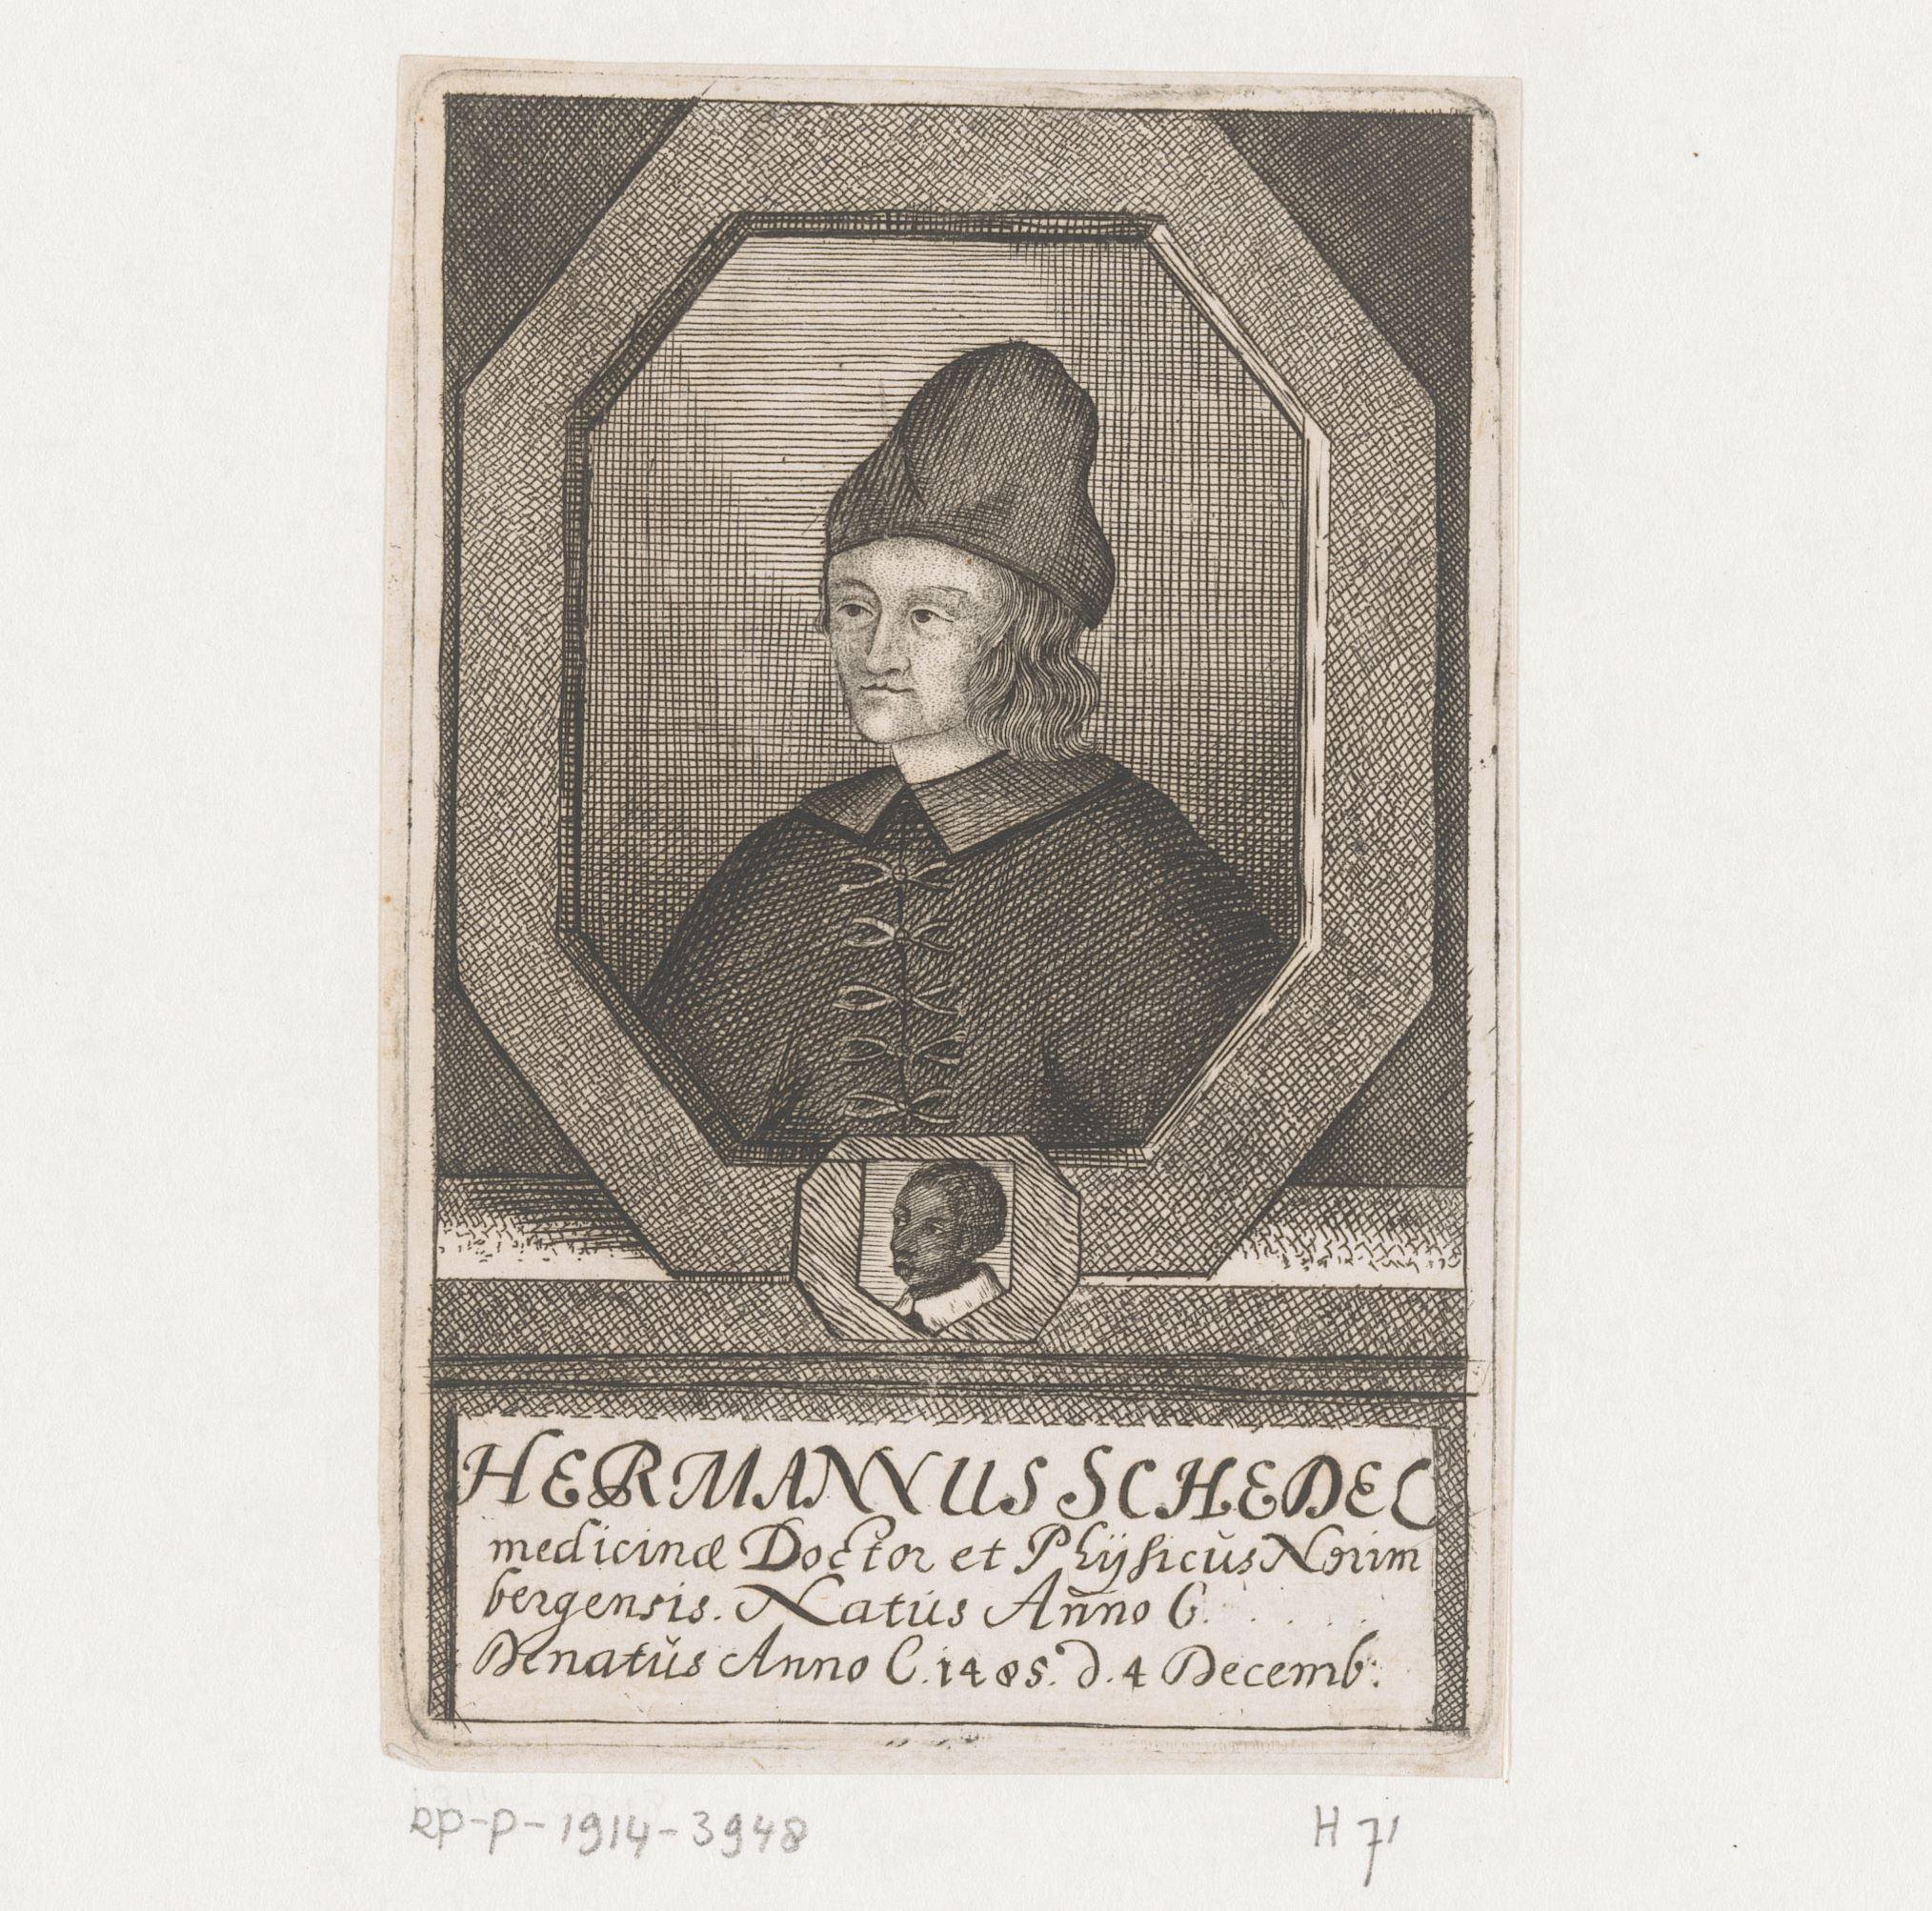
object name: print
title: Portret van Hermann Schedel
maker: johann jacob schollenberger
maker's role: print maker, publisher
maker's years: 1646-1689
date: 1656-1689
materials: paper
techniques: engraving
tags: historical persons, portrait of a writer, physician, doctor (+ portrait of scholar, scientist)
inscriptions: collector's mark: Lugt 2228